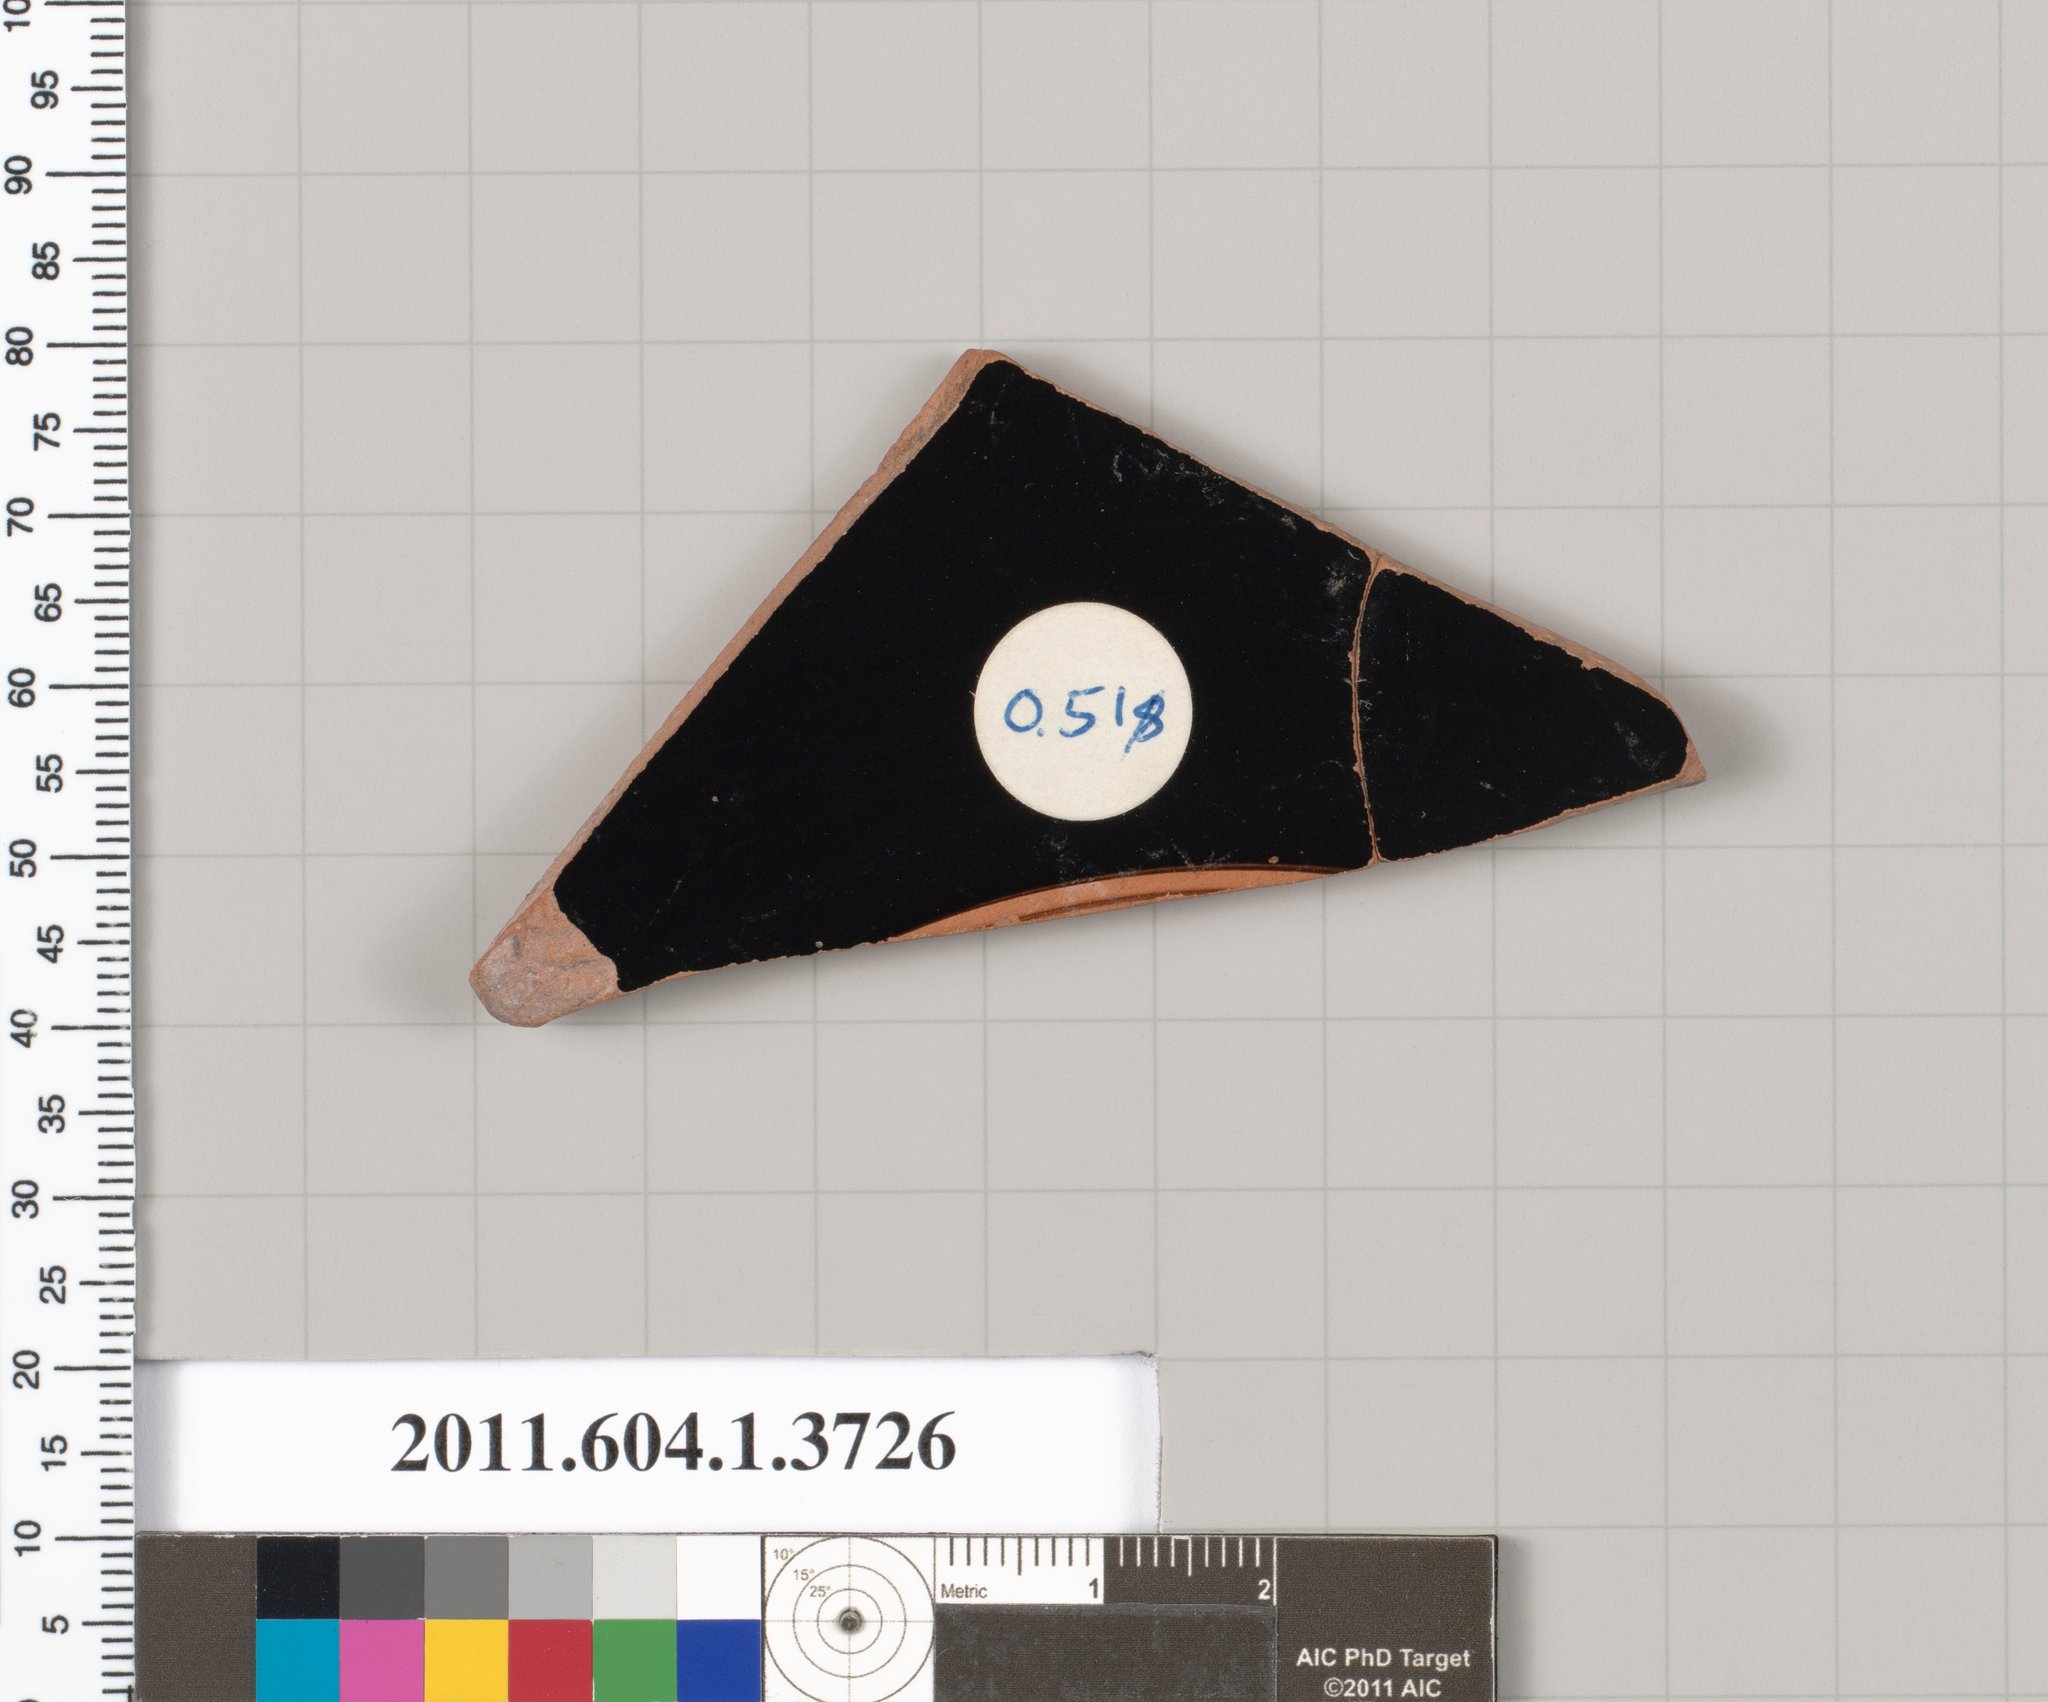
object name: kylix fragment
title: Terracotta fragment of a kylix (drinking cup)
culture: greek, attic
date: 470-450 BCE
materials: terracotta